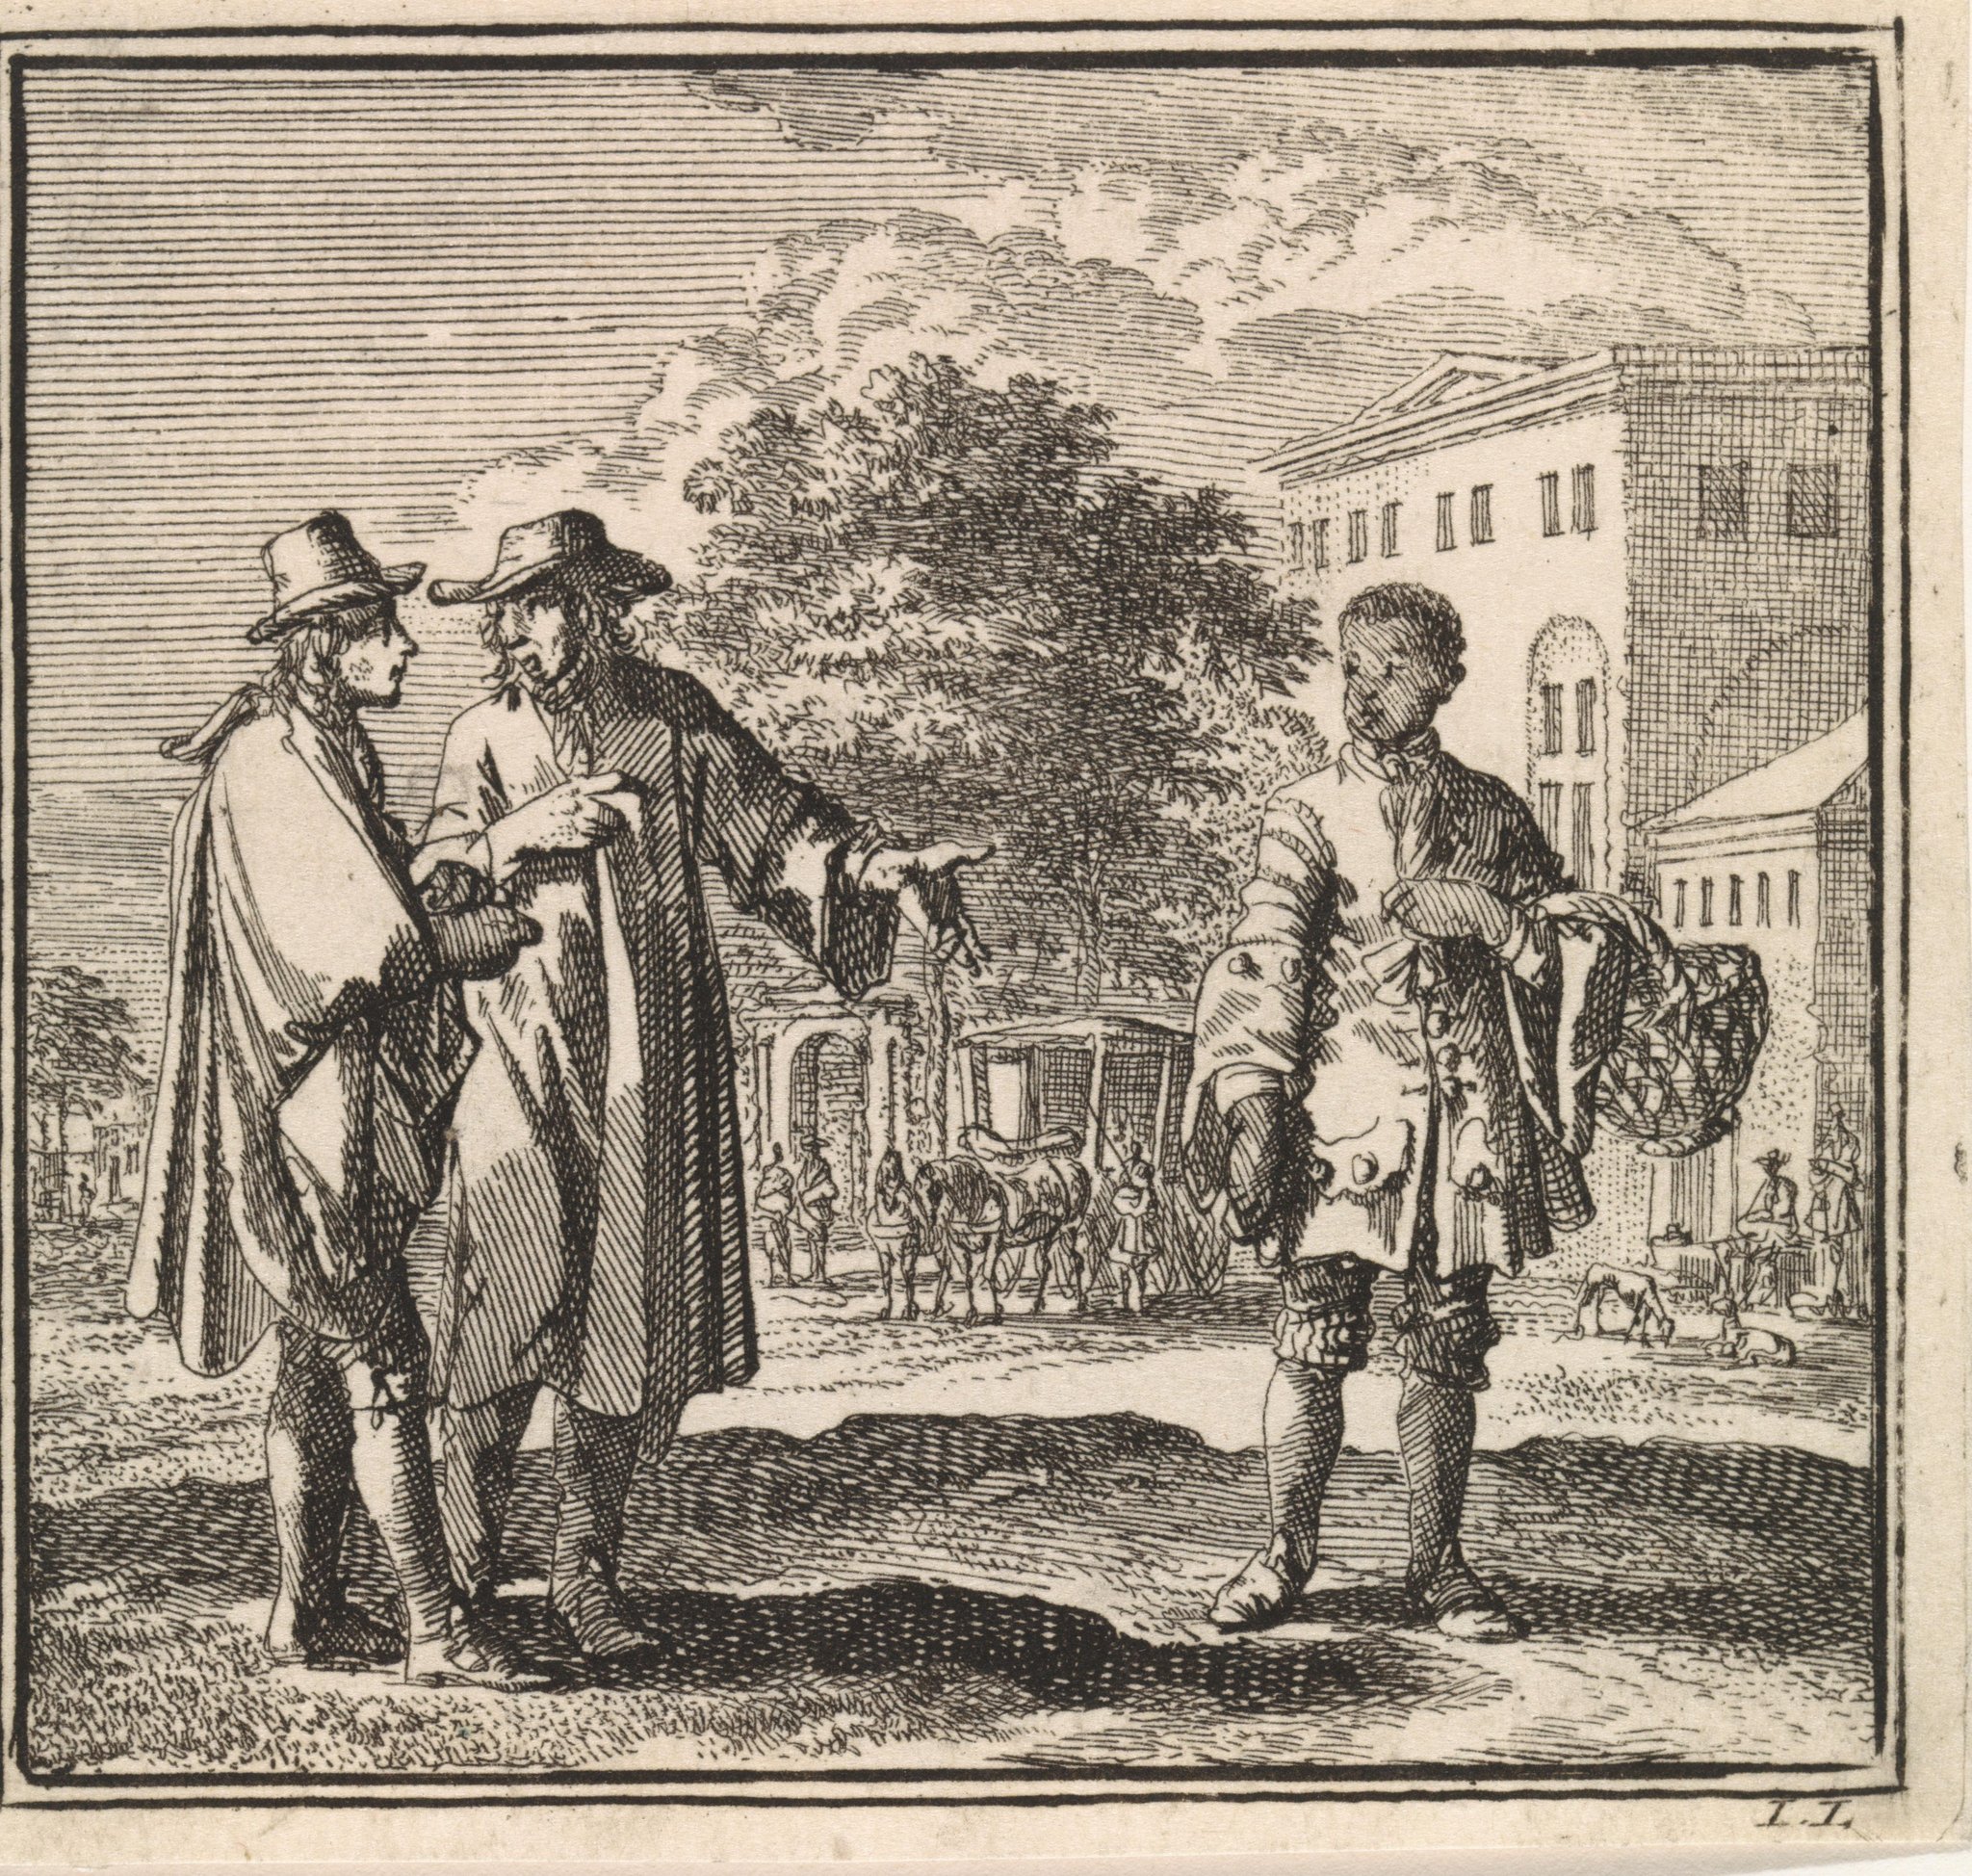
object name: print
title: Vrouw schrobt de vloer met een luiwagen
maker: jan luyken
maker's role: draughtsman, print maker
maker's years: 1649-1712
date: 1711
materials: paper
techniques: etching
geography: amsterdam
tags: picture, painting, shrubs: broom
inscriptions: collector's mark: Lugt 2228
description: Proefdruk van illustratie voor: Luyken, Jan. Het leerzaam huisraad, vertoond in vyftig konstige figuuren, met godlyke spreuken en stichtelyke verzen: Pieter Arentsz. II (wed.) en Cornelis van der Sys, 1711, p. 74.